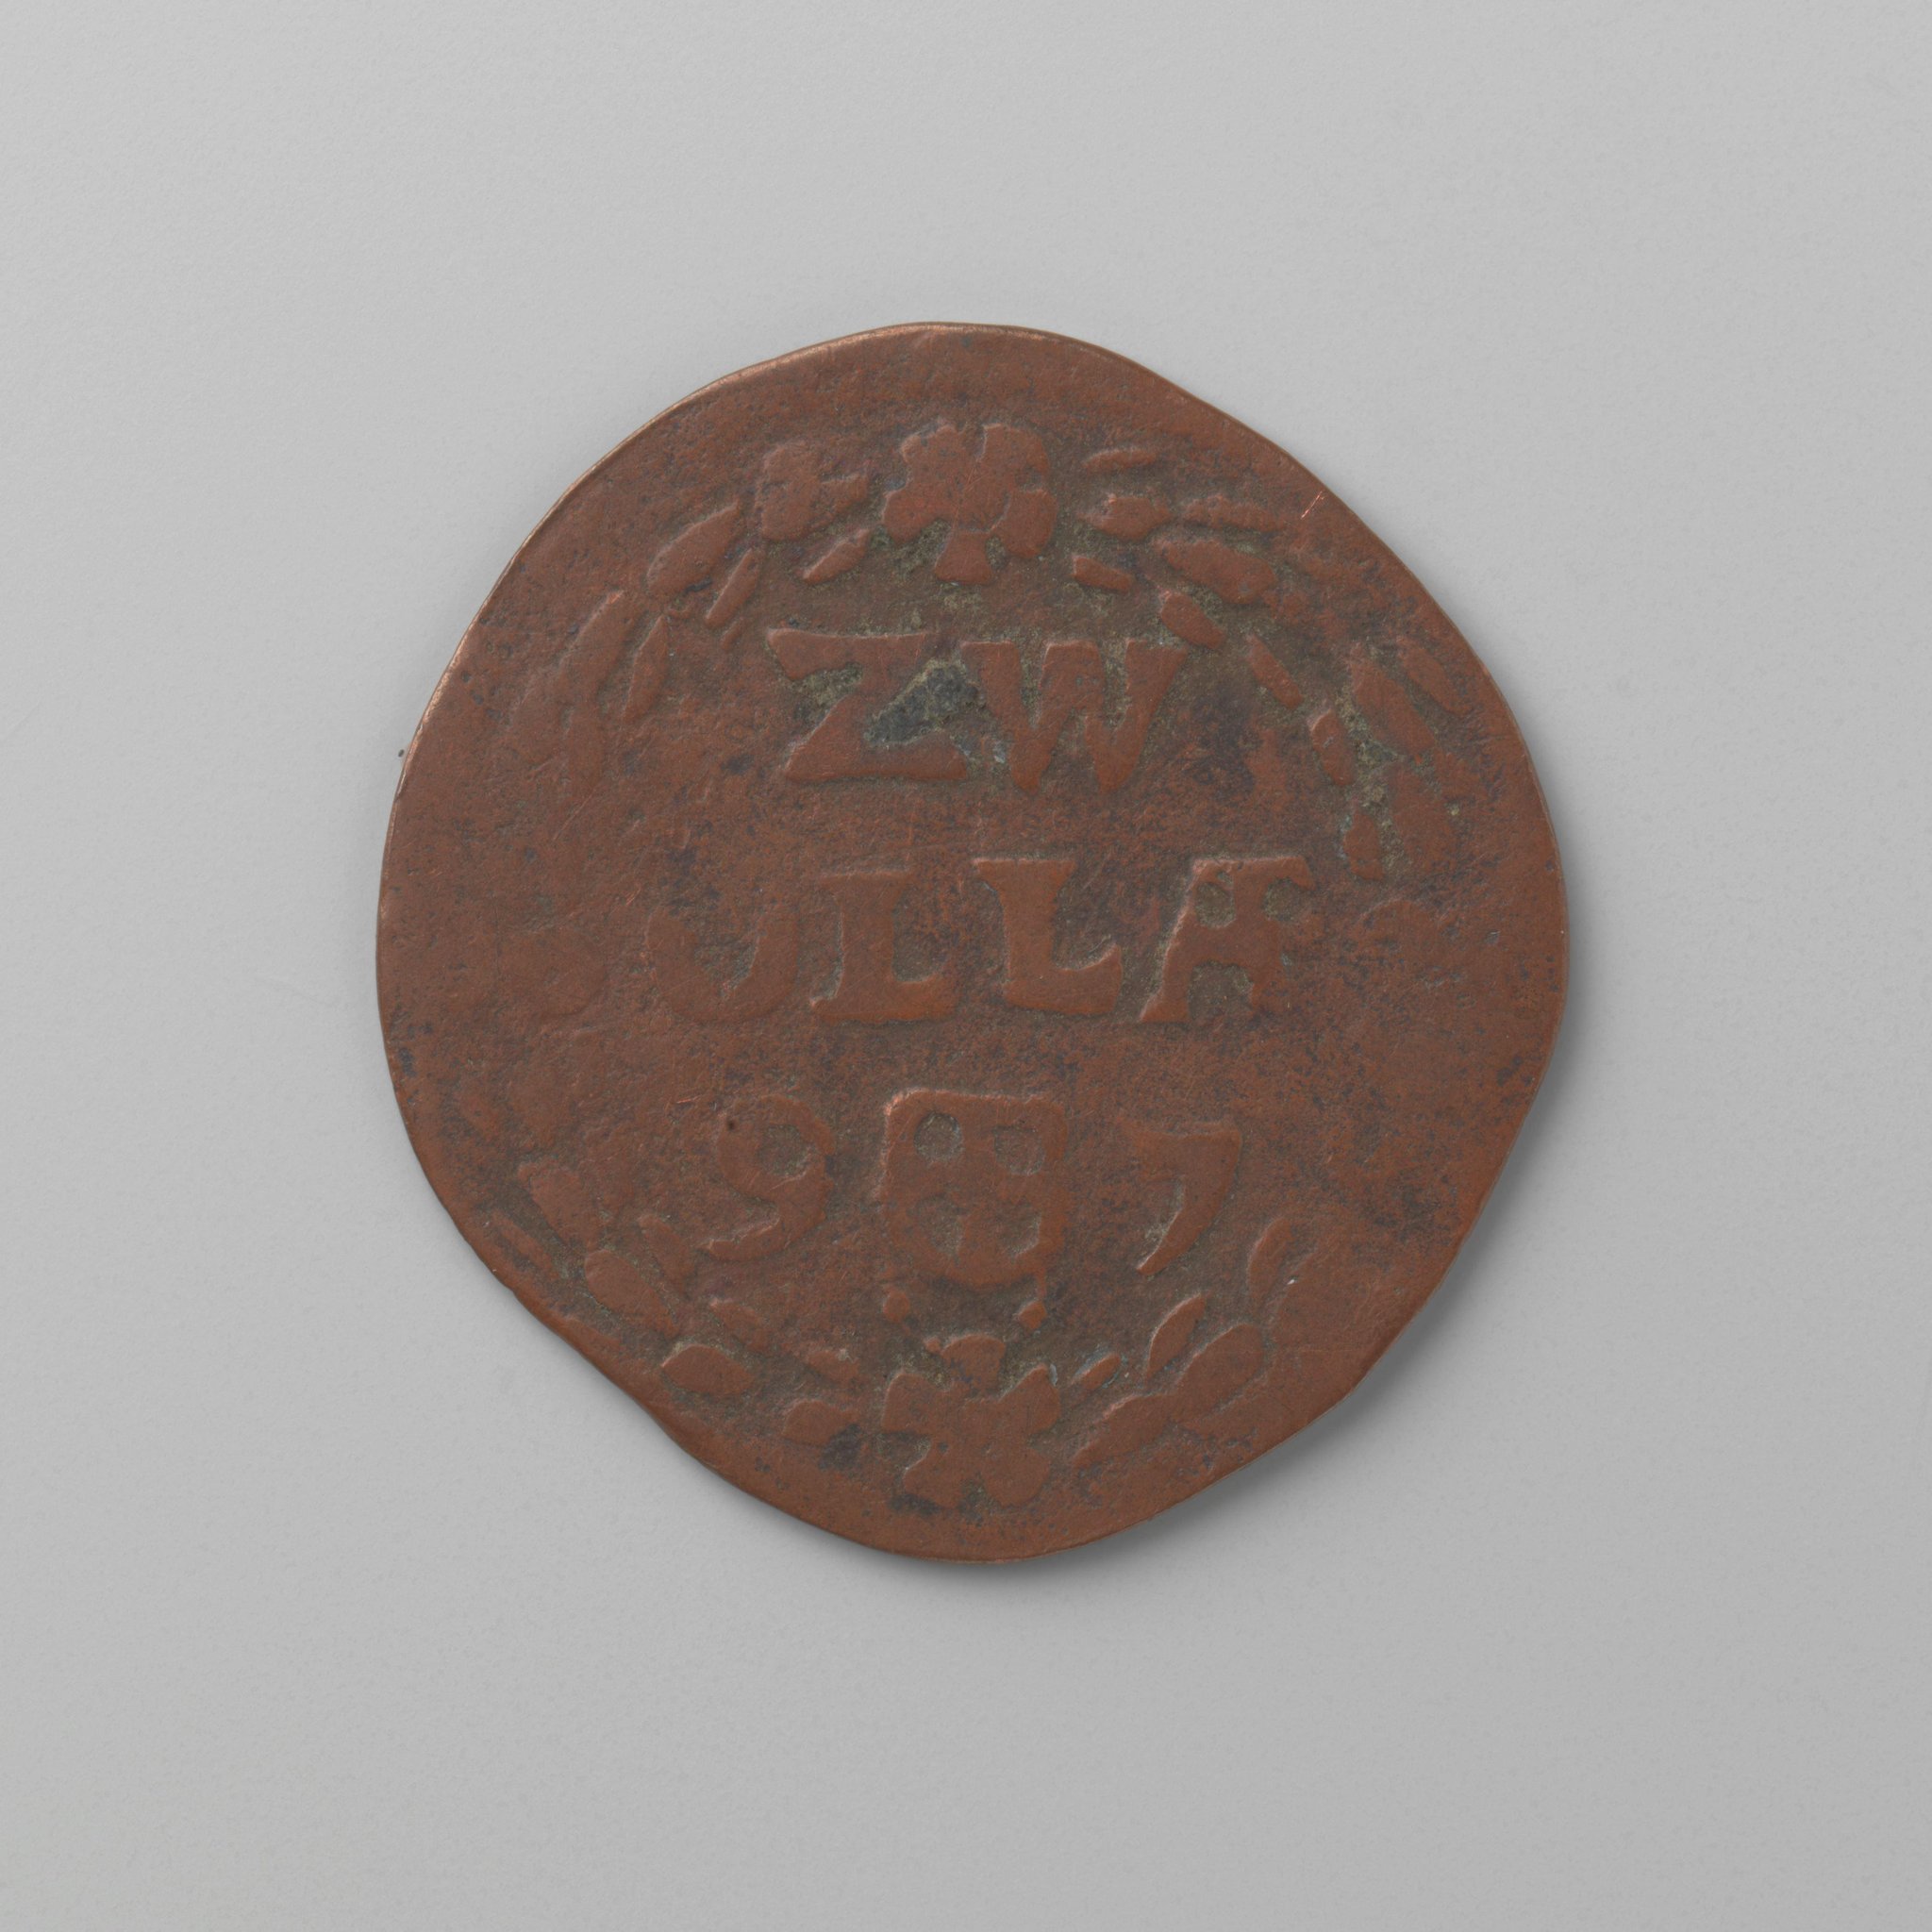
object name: coin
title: Zwolle, duit, 1597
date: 1597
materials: copper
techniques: striking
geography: zwolle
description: Koperen munt. Voorzijde: wapenschild van Zwolle. Keerzijde: tweeregelig opschrift, waaronder jaartal 97 tussen wapenschildje.